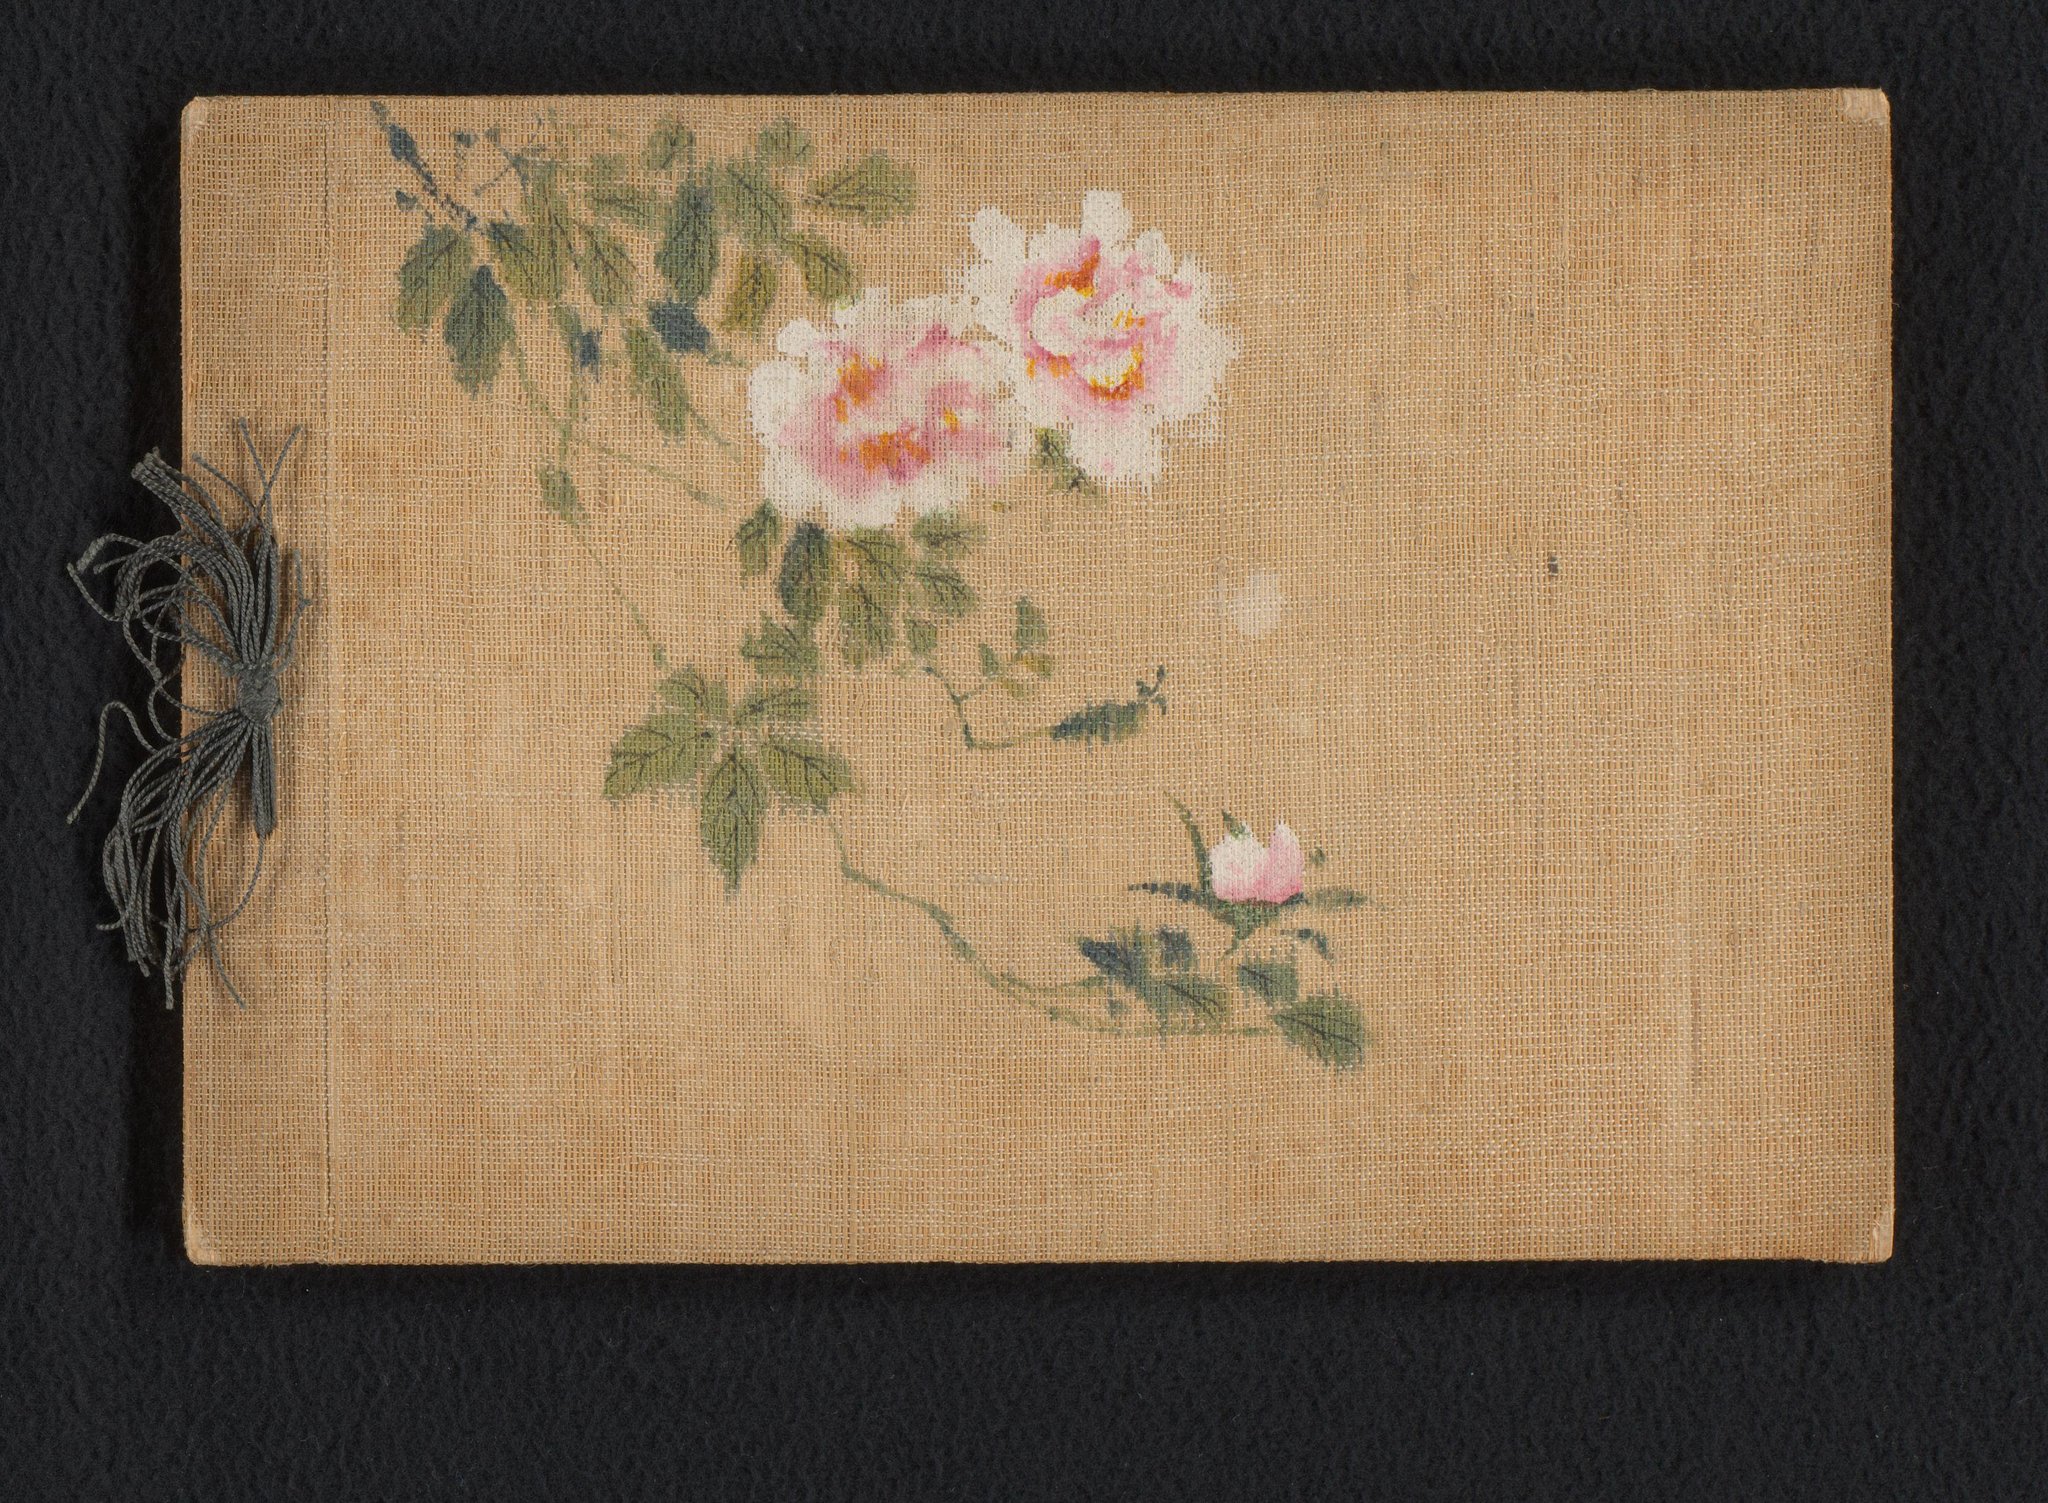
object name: book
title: Japanese Views and Characters Vol. II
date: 1905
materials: linen, paint, paper, yarns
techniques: photograph, hand coloring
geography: japan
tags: temple, shrine ~ hinduism, buddhism, jainism, island, trees: cherry-tree, ploughed field (+ landscape with figures, staffage), wrestling (sport), folk costume, regional costume, group games, party games